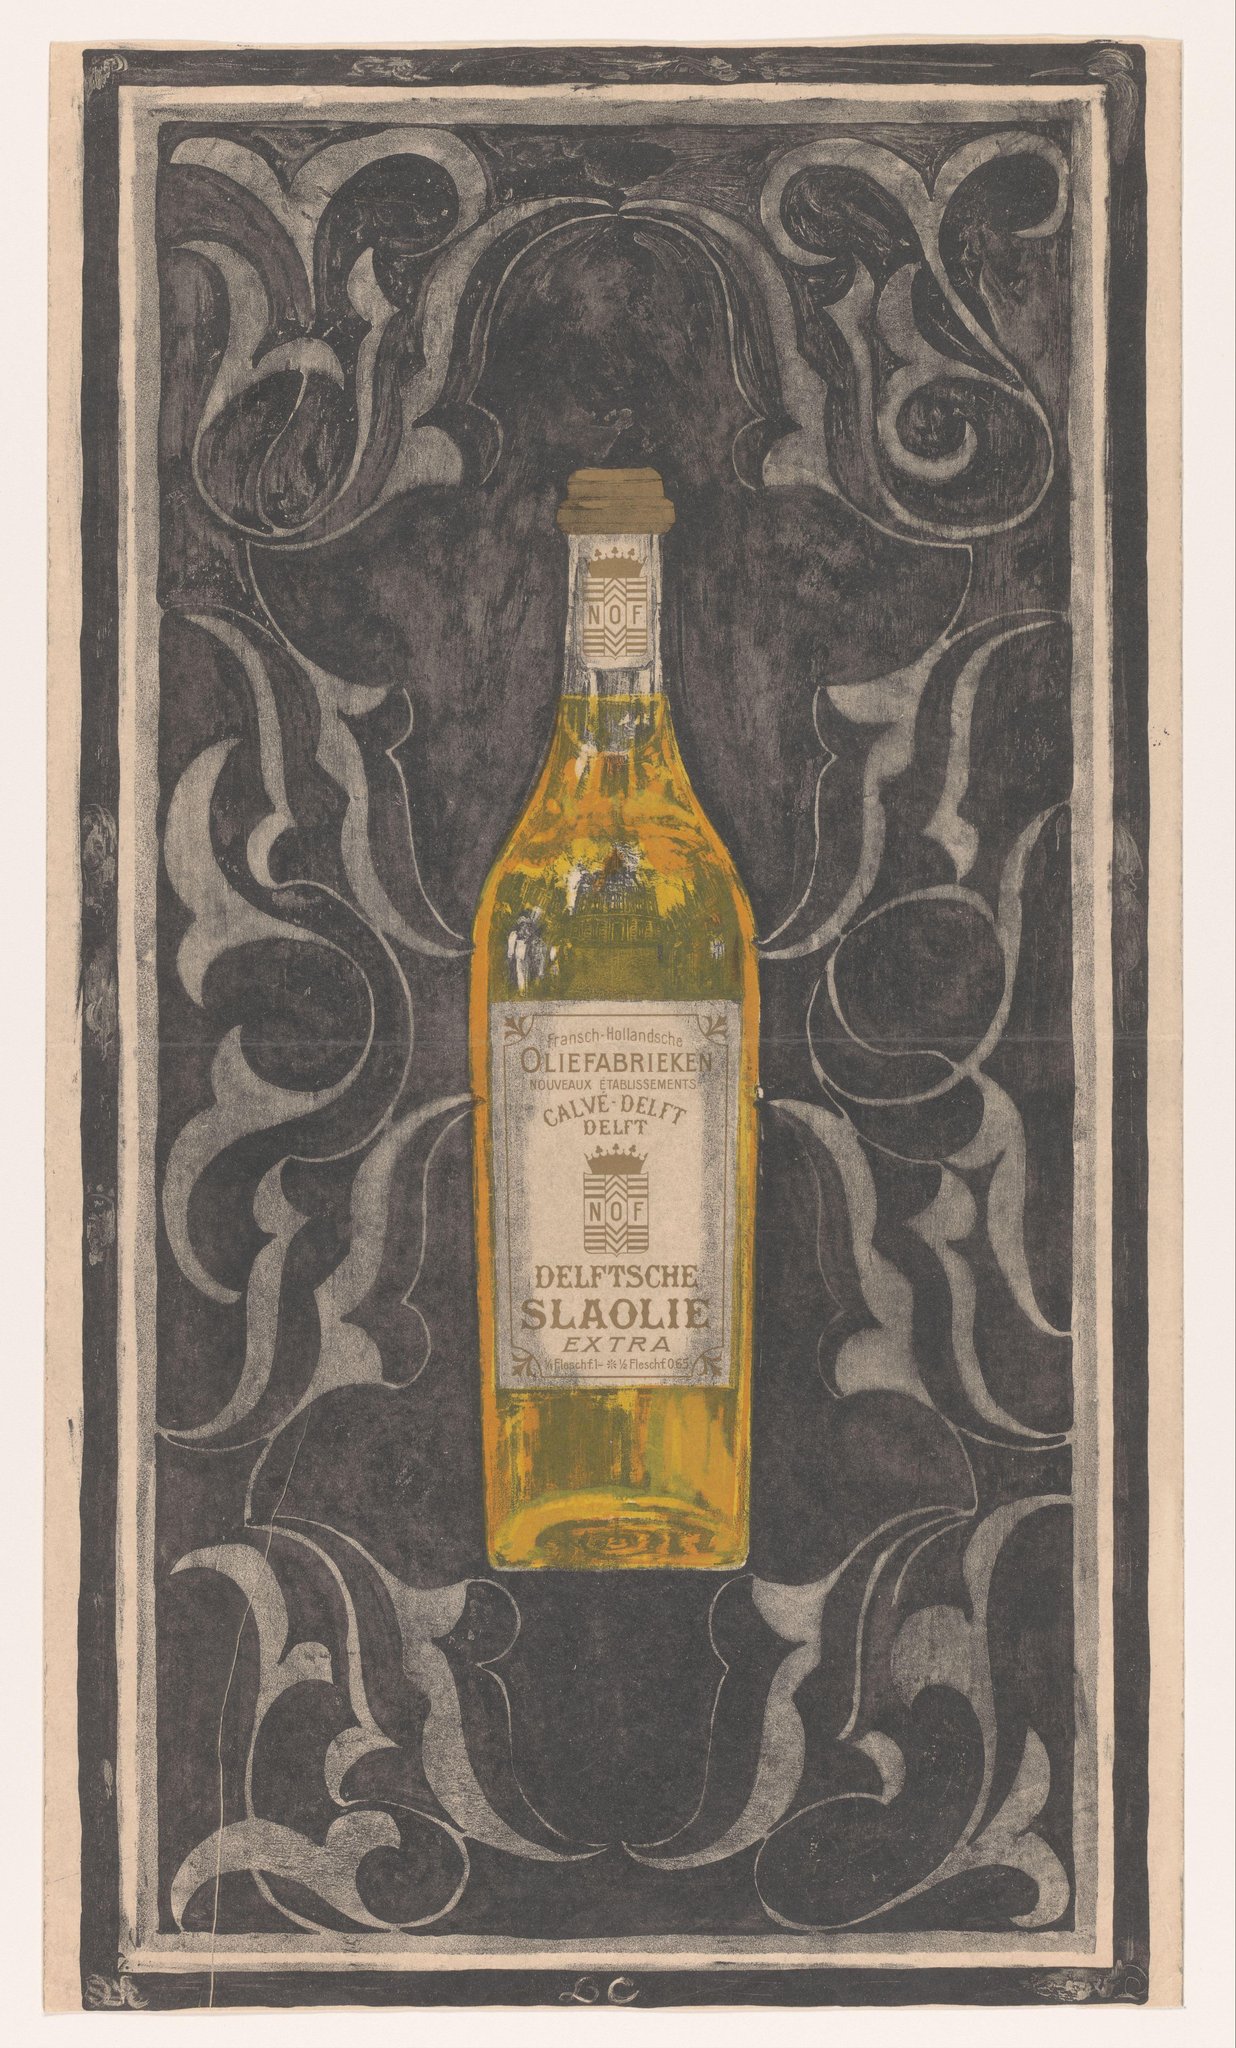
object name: poster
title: Affiche voor Delftsche Slaolie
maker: carel adolph lion cachet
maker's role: draughtsman, print maker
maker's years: 1864-1945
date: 1874-1945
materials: paper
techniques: lithograph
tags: oil, vinegar, sauces, poster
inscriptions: collector's mark: Lugt 2228